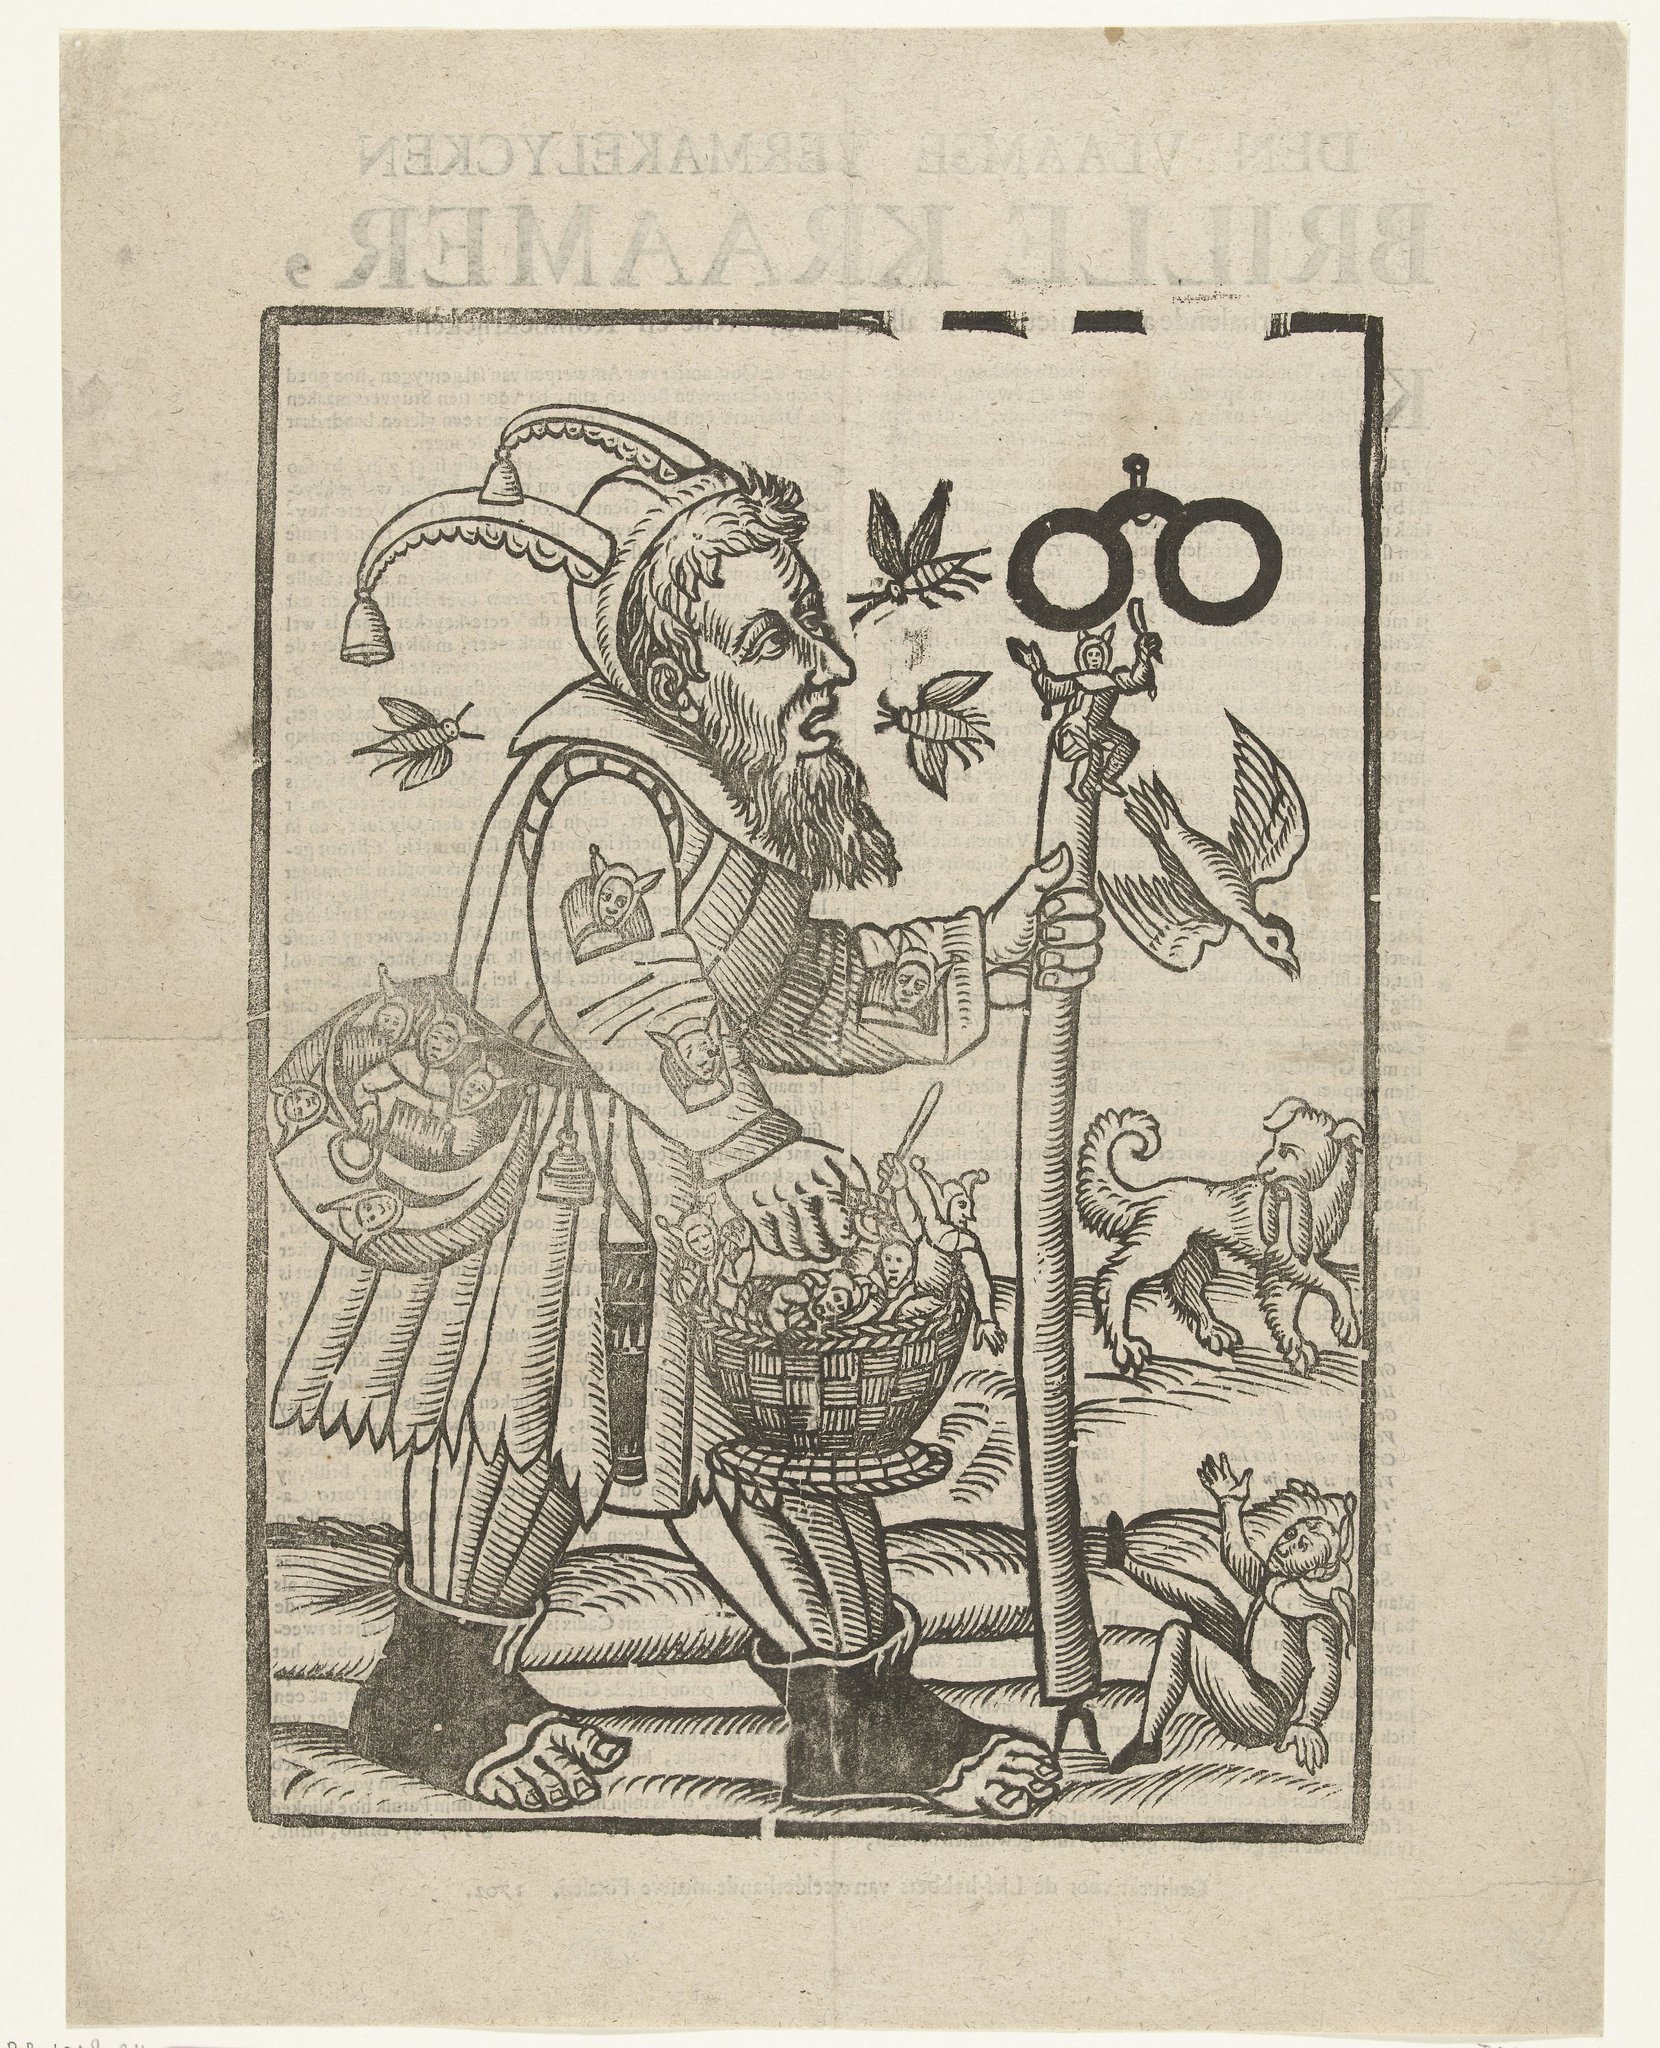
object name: print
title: De Vlaamse Brillenkramer, 1702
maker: Anonymous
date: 1702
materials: paper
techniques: letterpress printing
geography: low countries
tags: court jester, court fool, pedlar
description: Blad met op een zijde een beschrijving in twee kolommen van de Franse nederlaag in de slag bij Luzarra, 15 augustus 1702. Op de andere zijde een spotprent van een oude dwaze (joodse?) kramer met een narrenkap, een tas met narren, een mand met narren in de hand en een staf waarop een nar zit. Bij de staf een bril. Vliegen zwermen om het hoofd van de kramer.